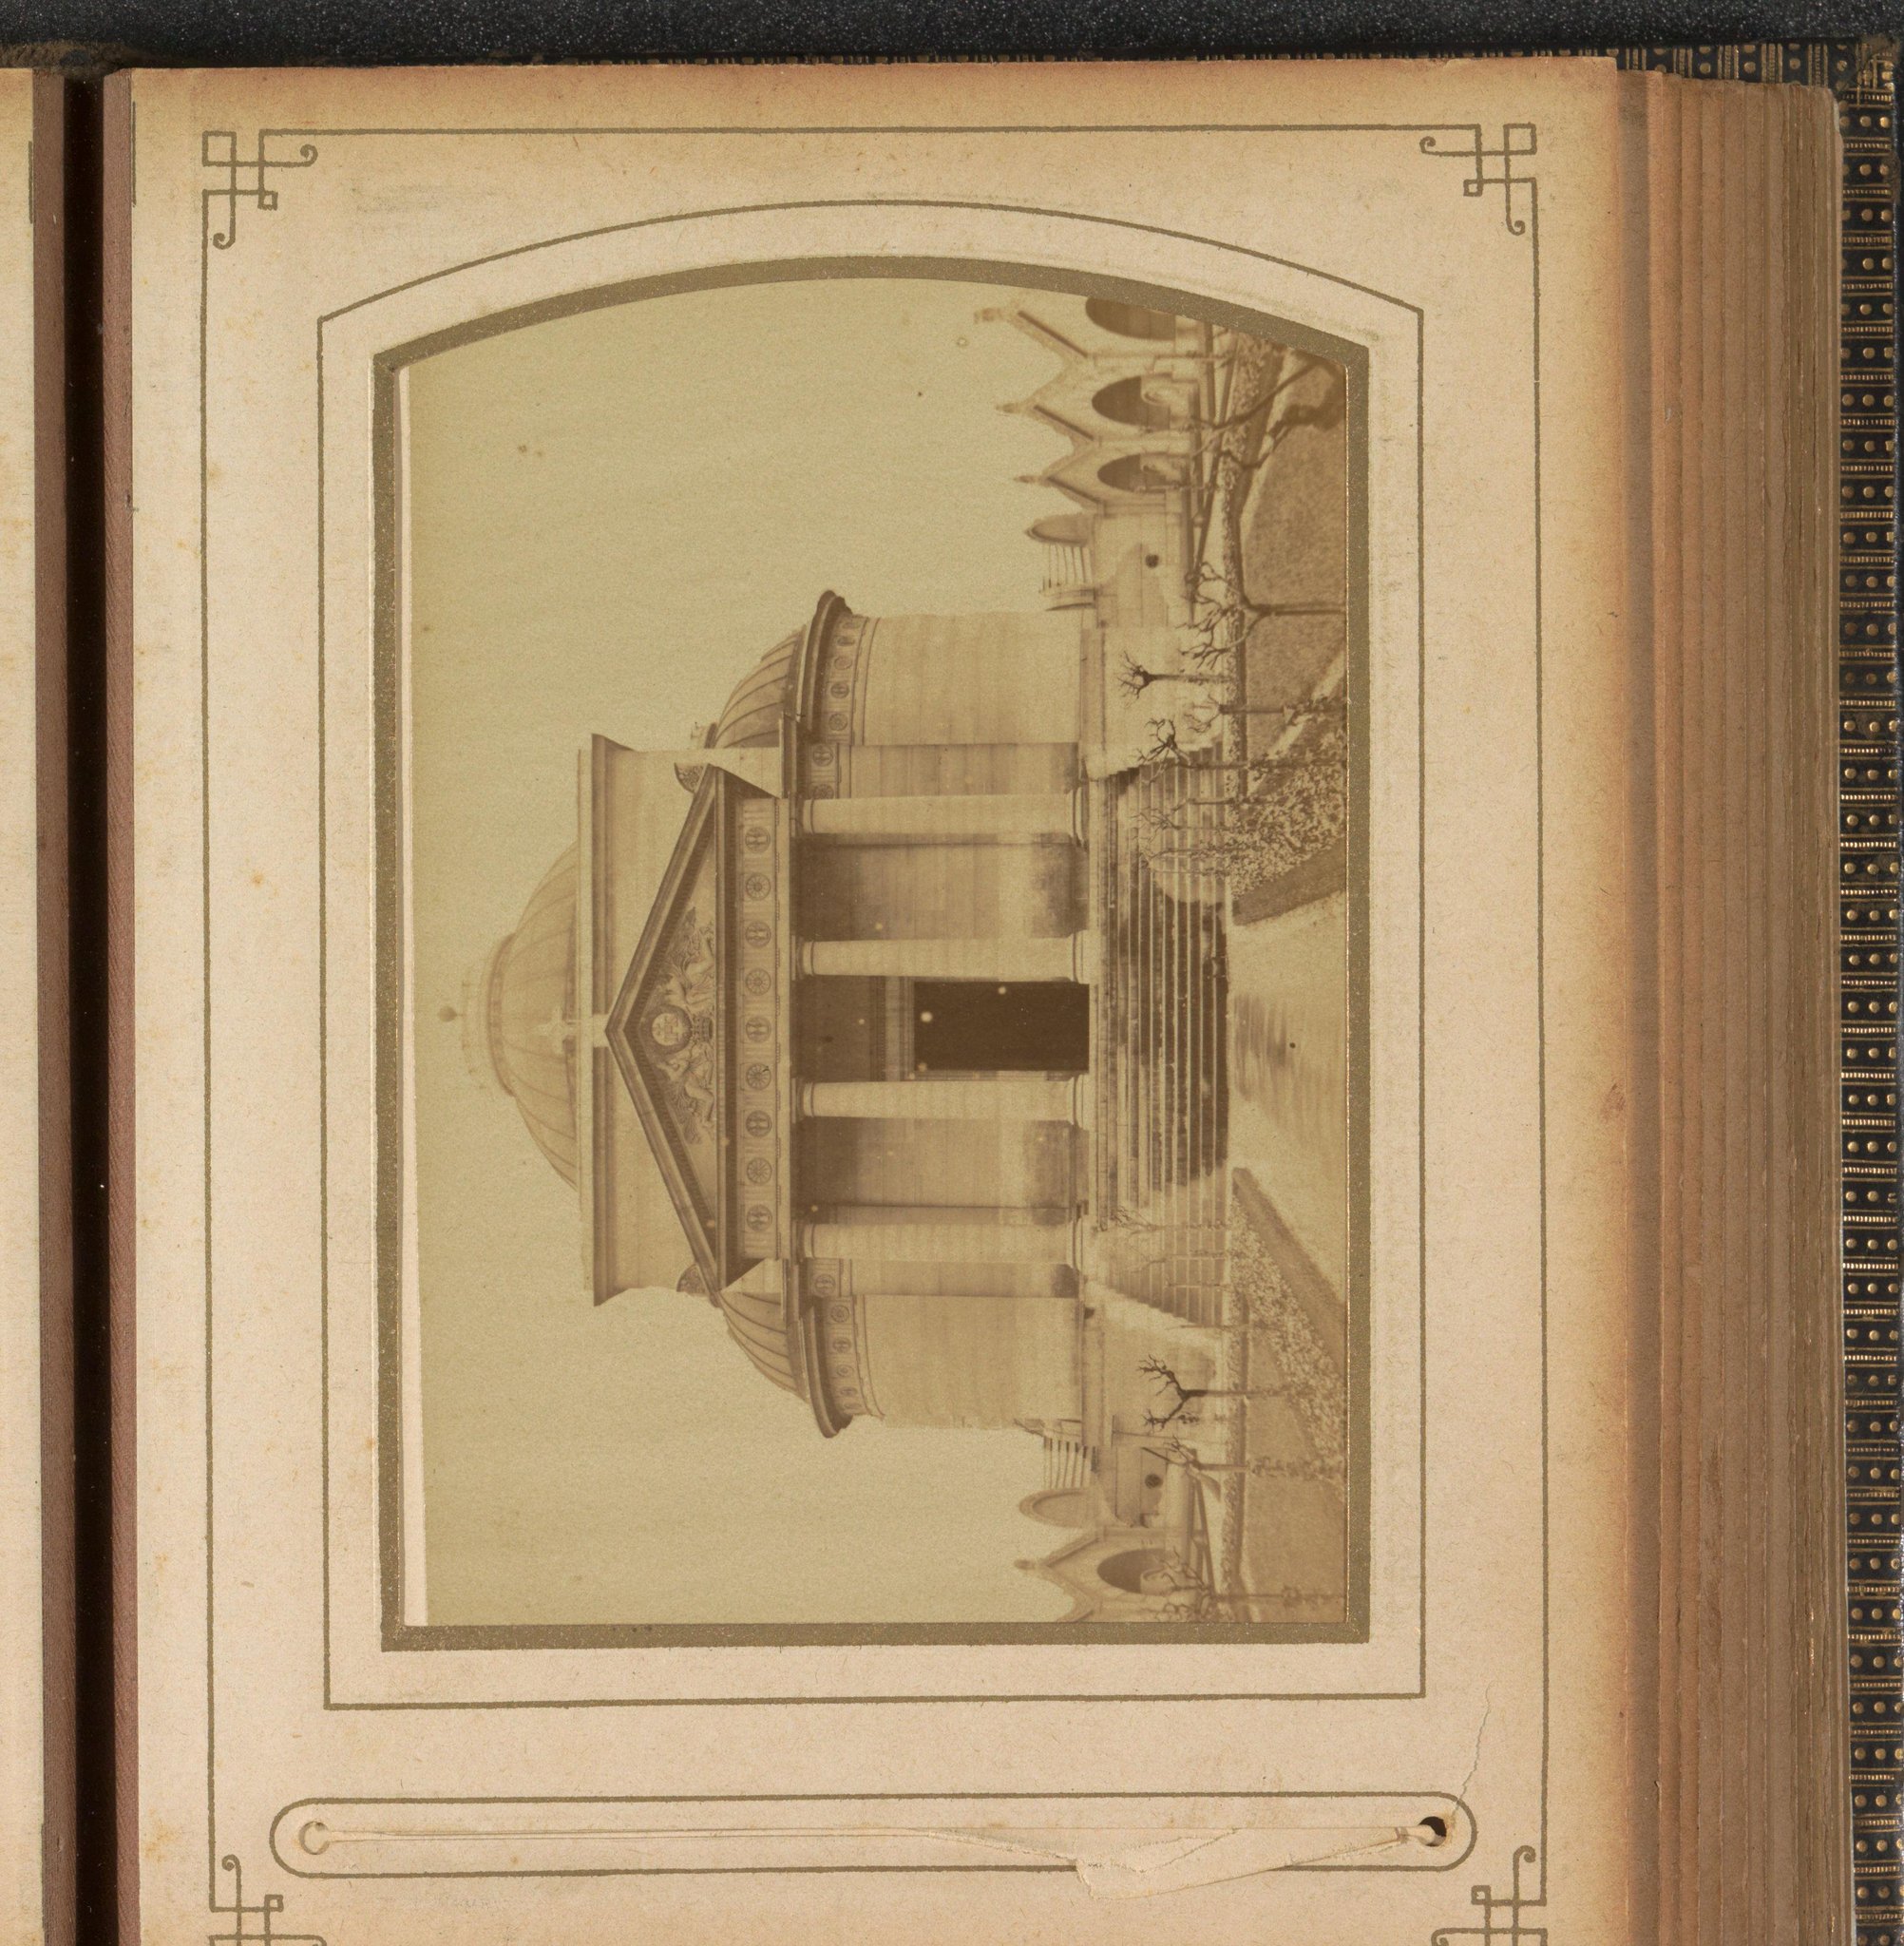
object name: photograph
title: Exterieur van de Chapelle expiatoire in Parijs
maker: Anonymous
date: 1870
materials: cardboard, paper, photographic support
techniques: albumen print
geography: paris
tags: dome ~ architecture, paris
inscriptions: inscription: ‘Chapelle du tombeau louis 14’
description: Onderdeel van Fotoalbum met kabinetfoto's van bezienswaardigheden in Parijs.